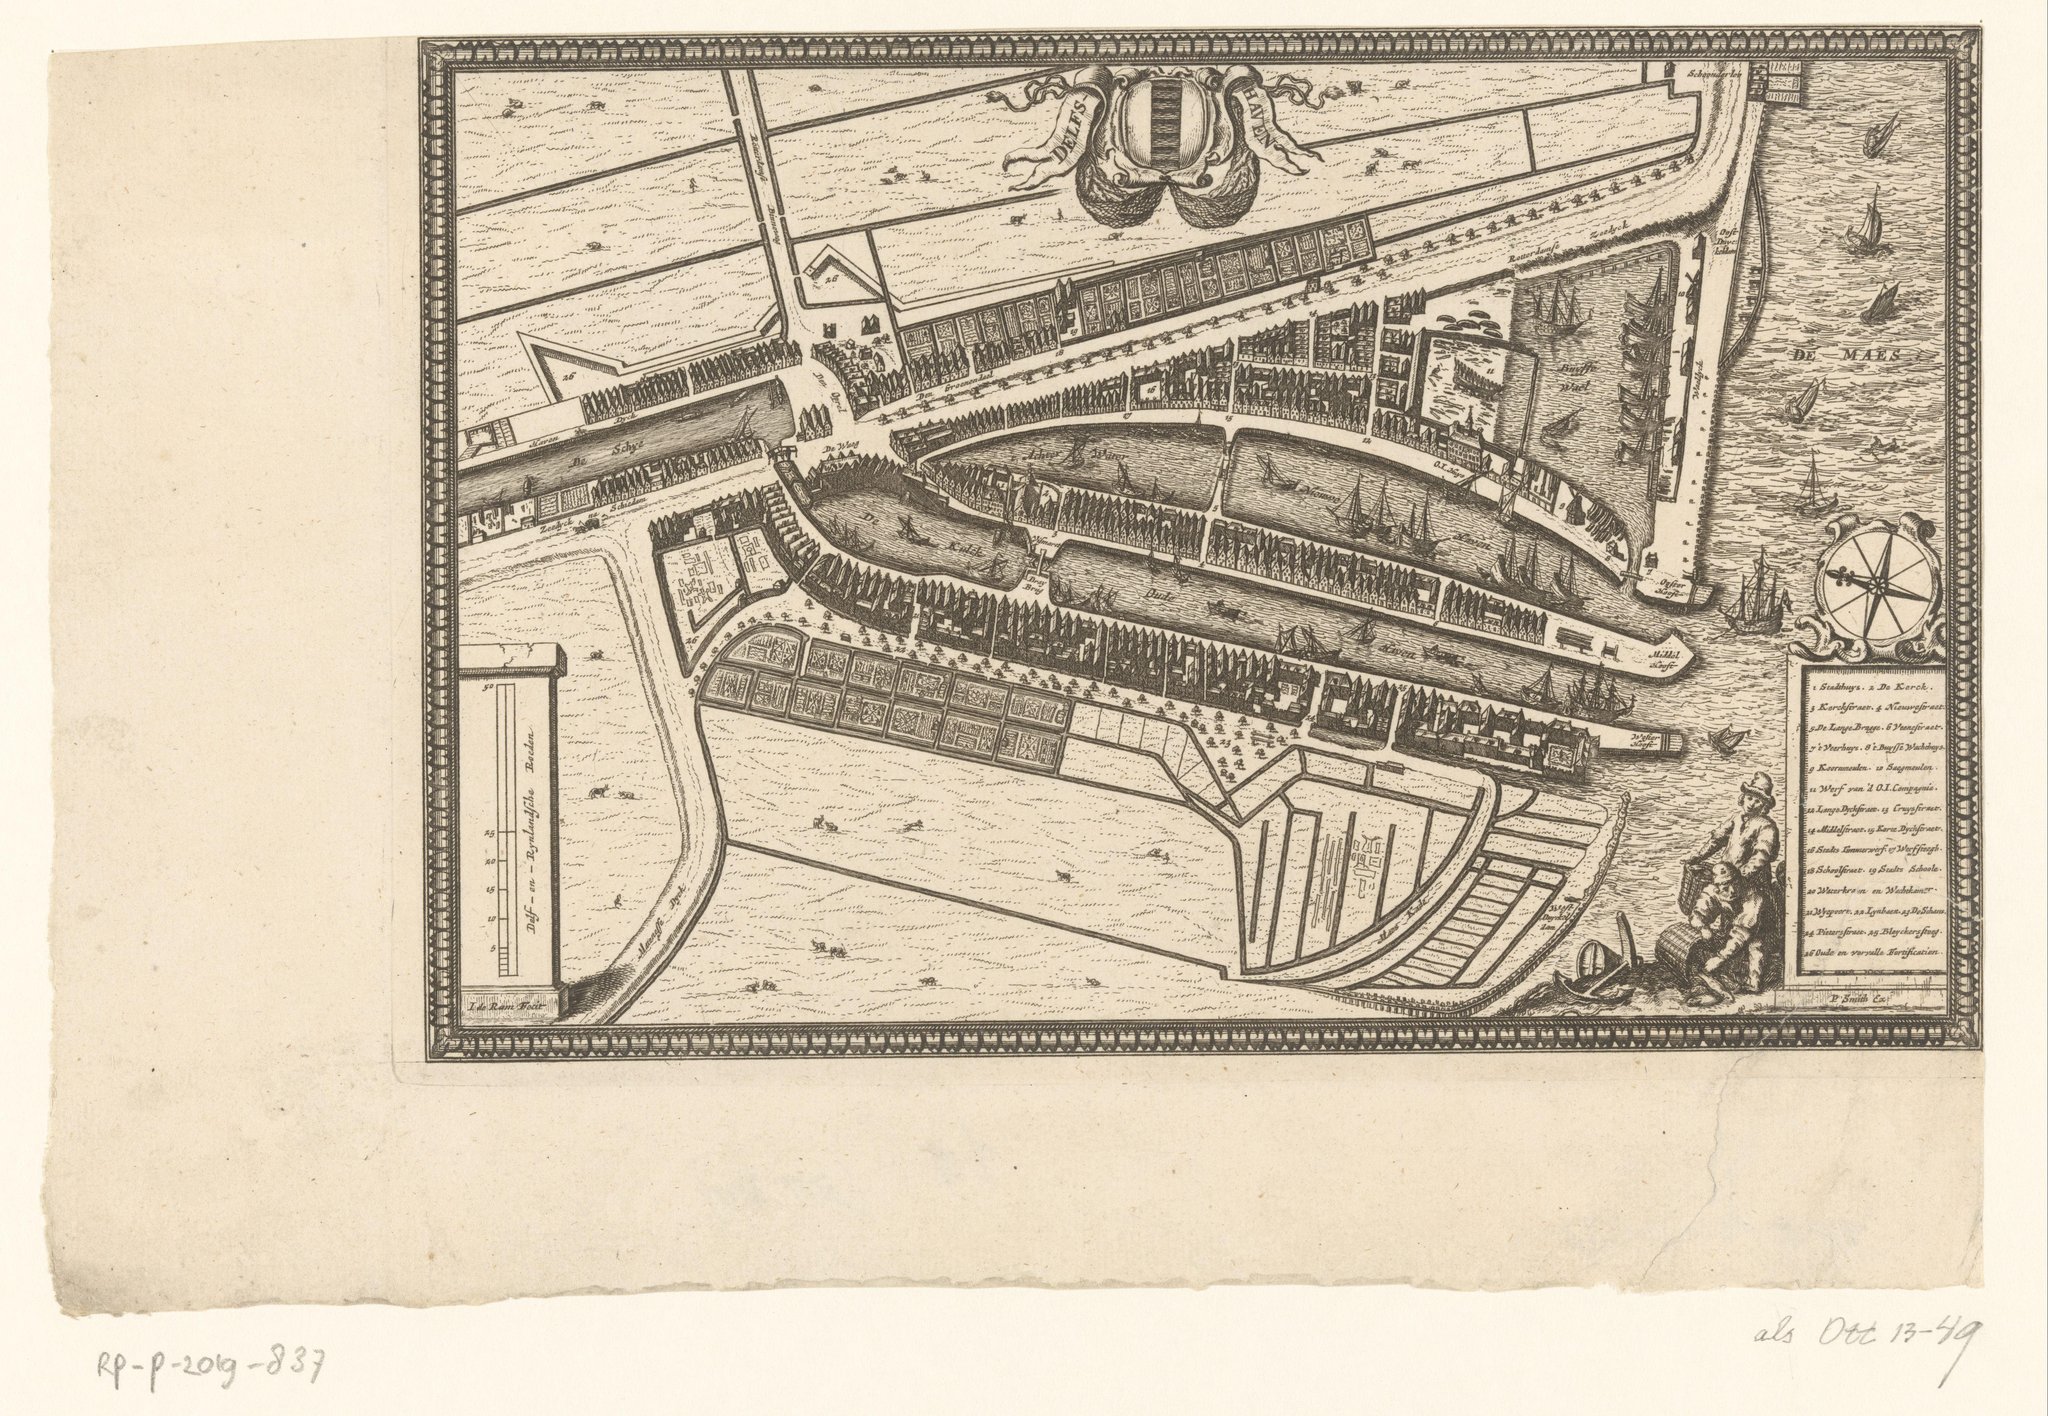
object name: area plan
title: Plattegrond van Delfshaven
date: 1678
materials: paper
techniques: etching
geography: amsterdam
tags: harbour, maps of cities, delfshaven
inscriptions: collector's mark: Lugt 2228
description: Prent voor het eerst uitgegeven als onderdeel van de rand van de zogenaamde Kaart Figuratief (Caerte figuratyff / Kaerte figuratyf) van Delft, een wandkaart van Delft uit 1678 (zie RP-P-AO-11-8A). De prent werd later gebruikt in een publicatie uit 1680 (Delft: Arnold Bon) en voor een heruitgave van de Kaart Figuratief door Pieter Mortier (I) in 1703.